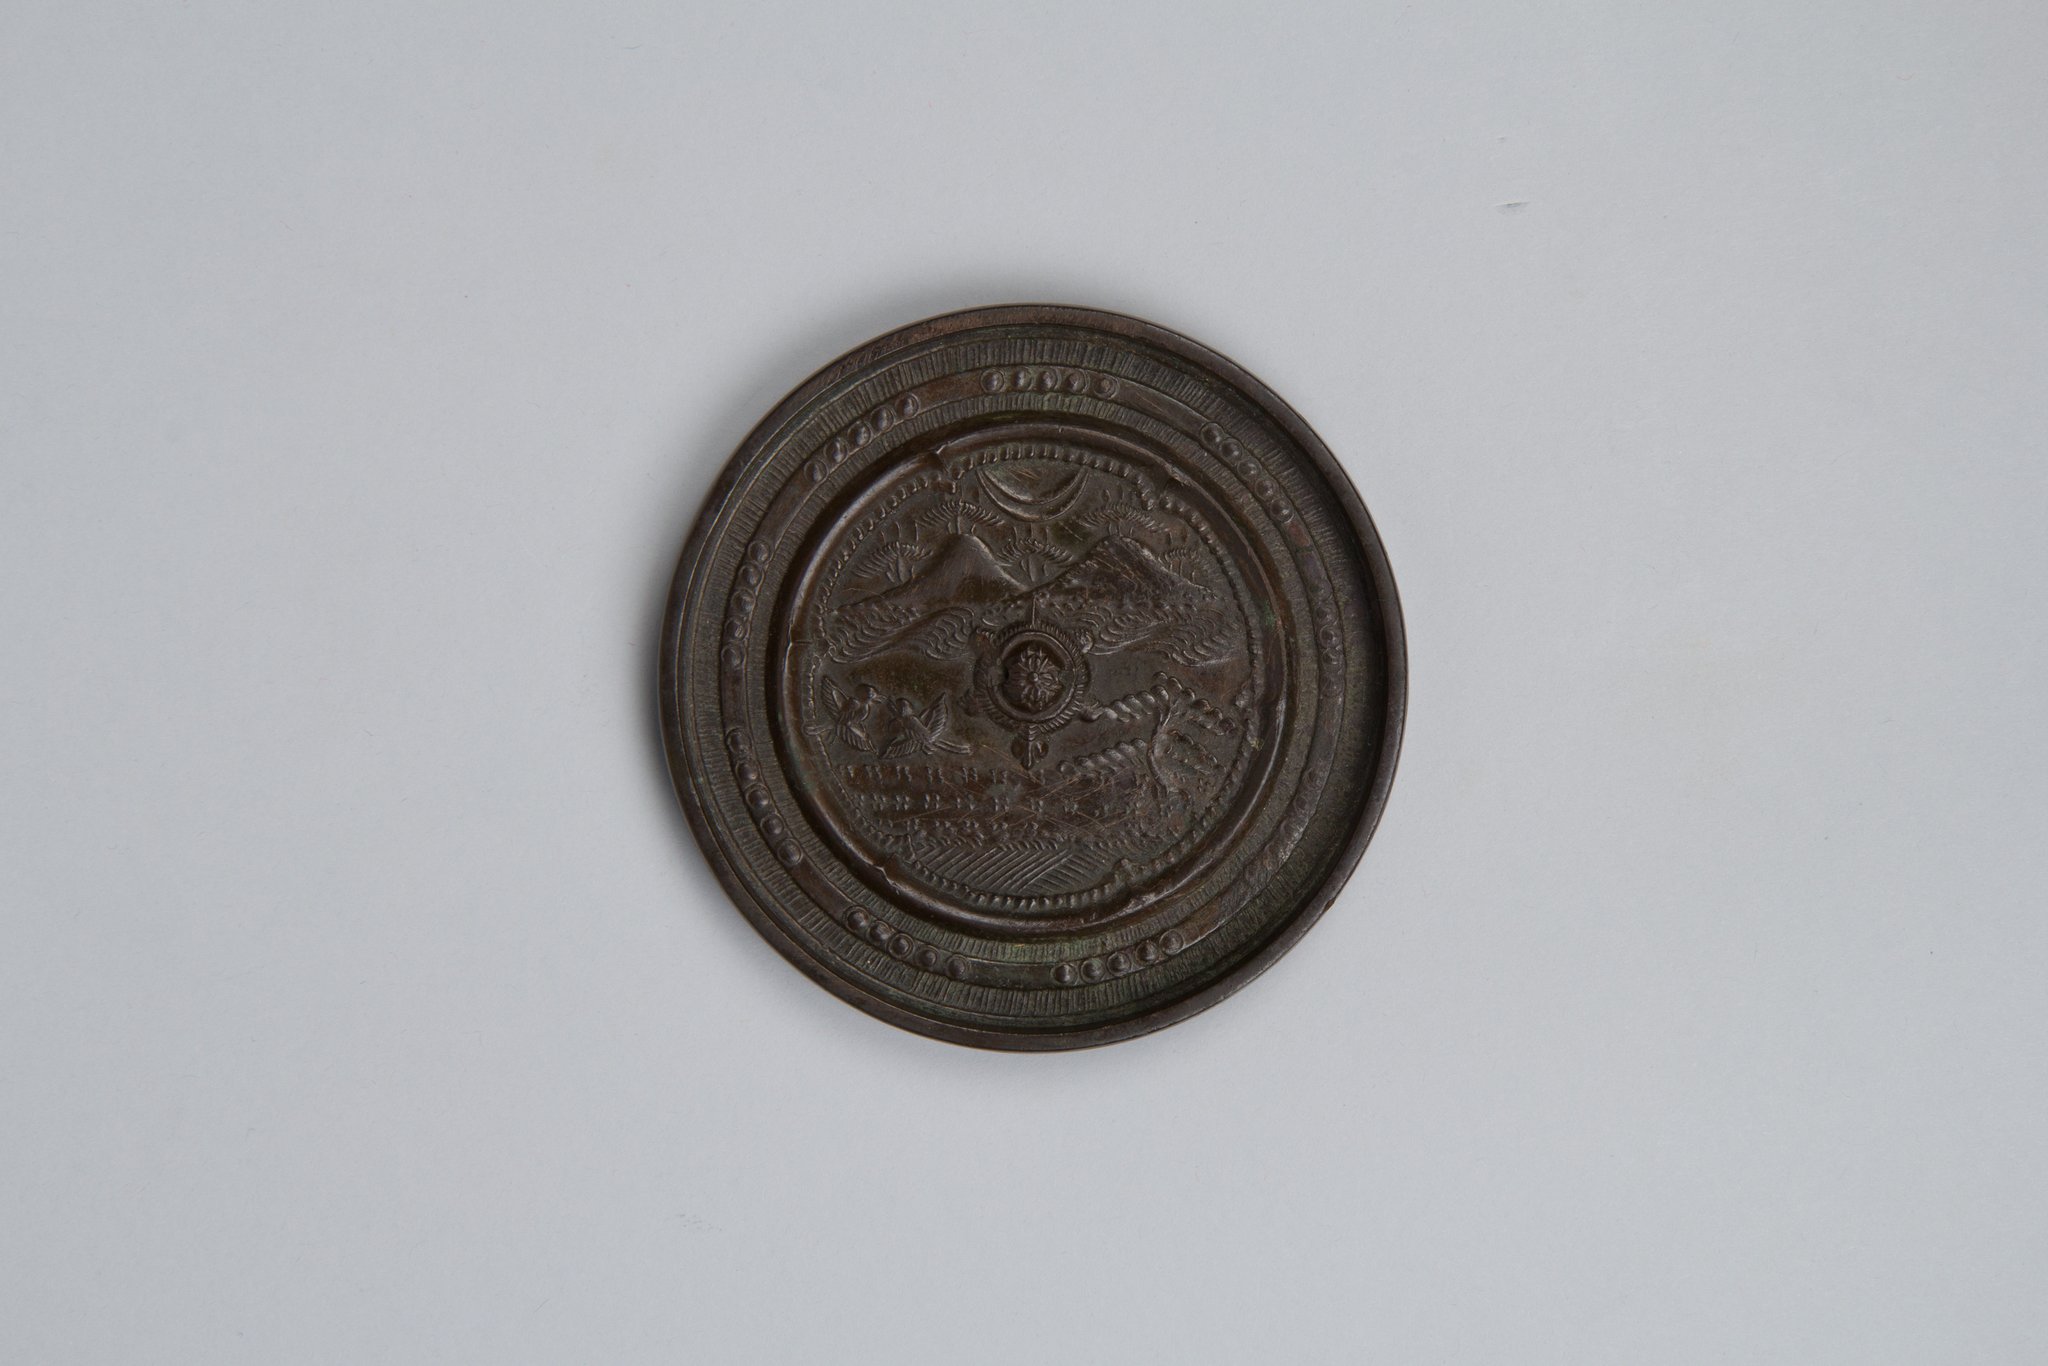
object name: mirror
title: Mirror with Decoration of Japanese Landscape: Pines on Shore and Crescent Moon over Mountains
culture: japanese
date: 1392-1573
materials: bronze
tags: birds,mountains